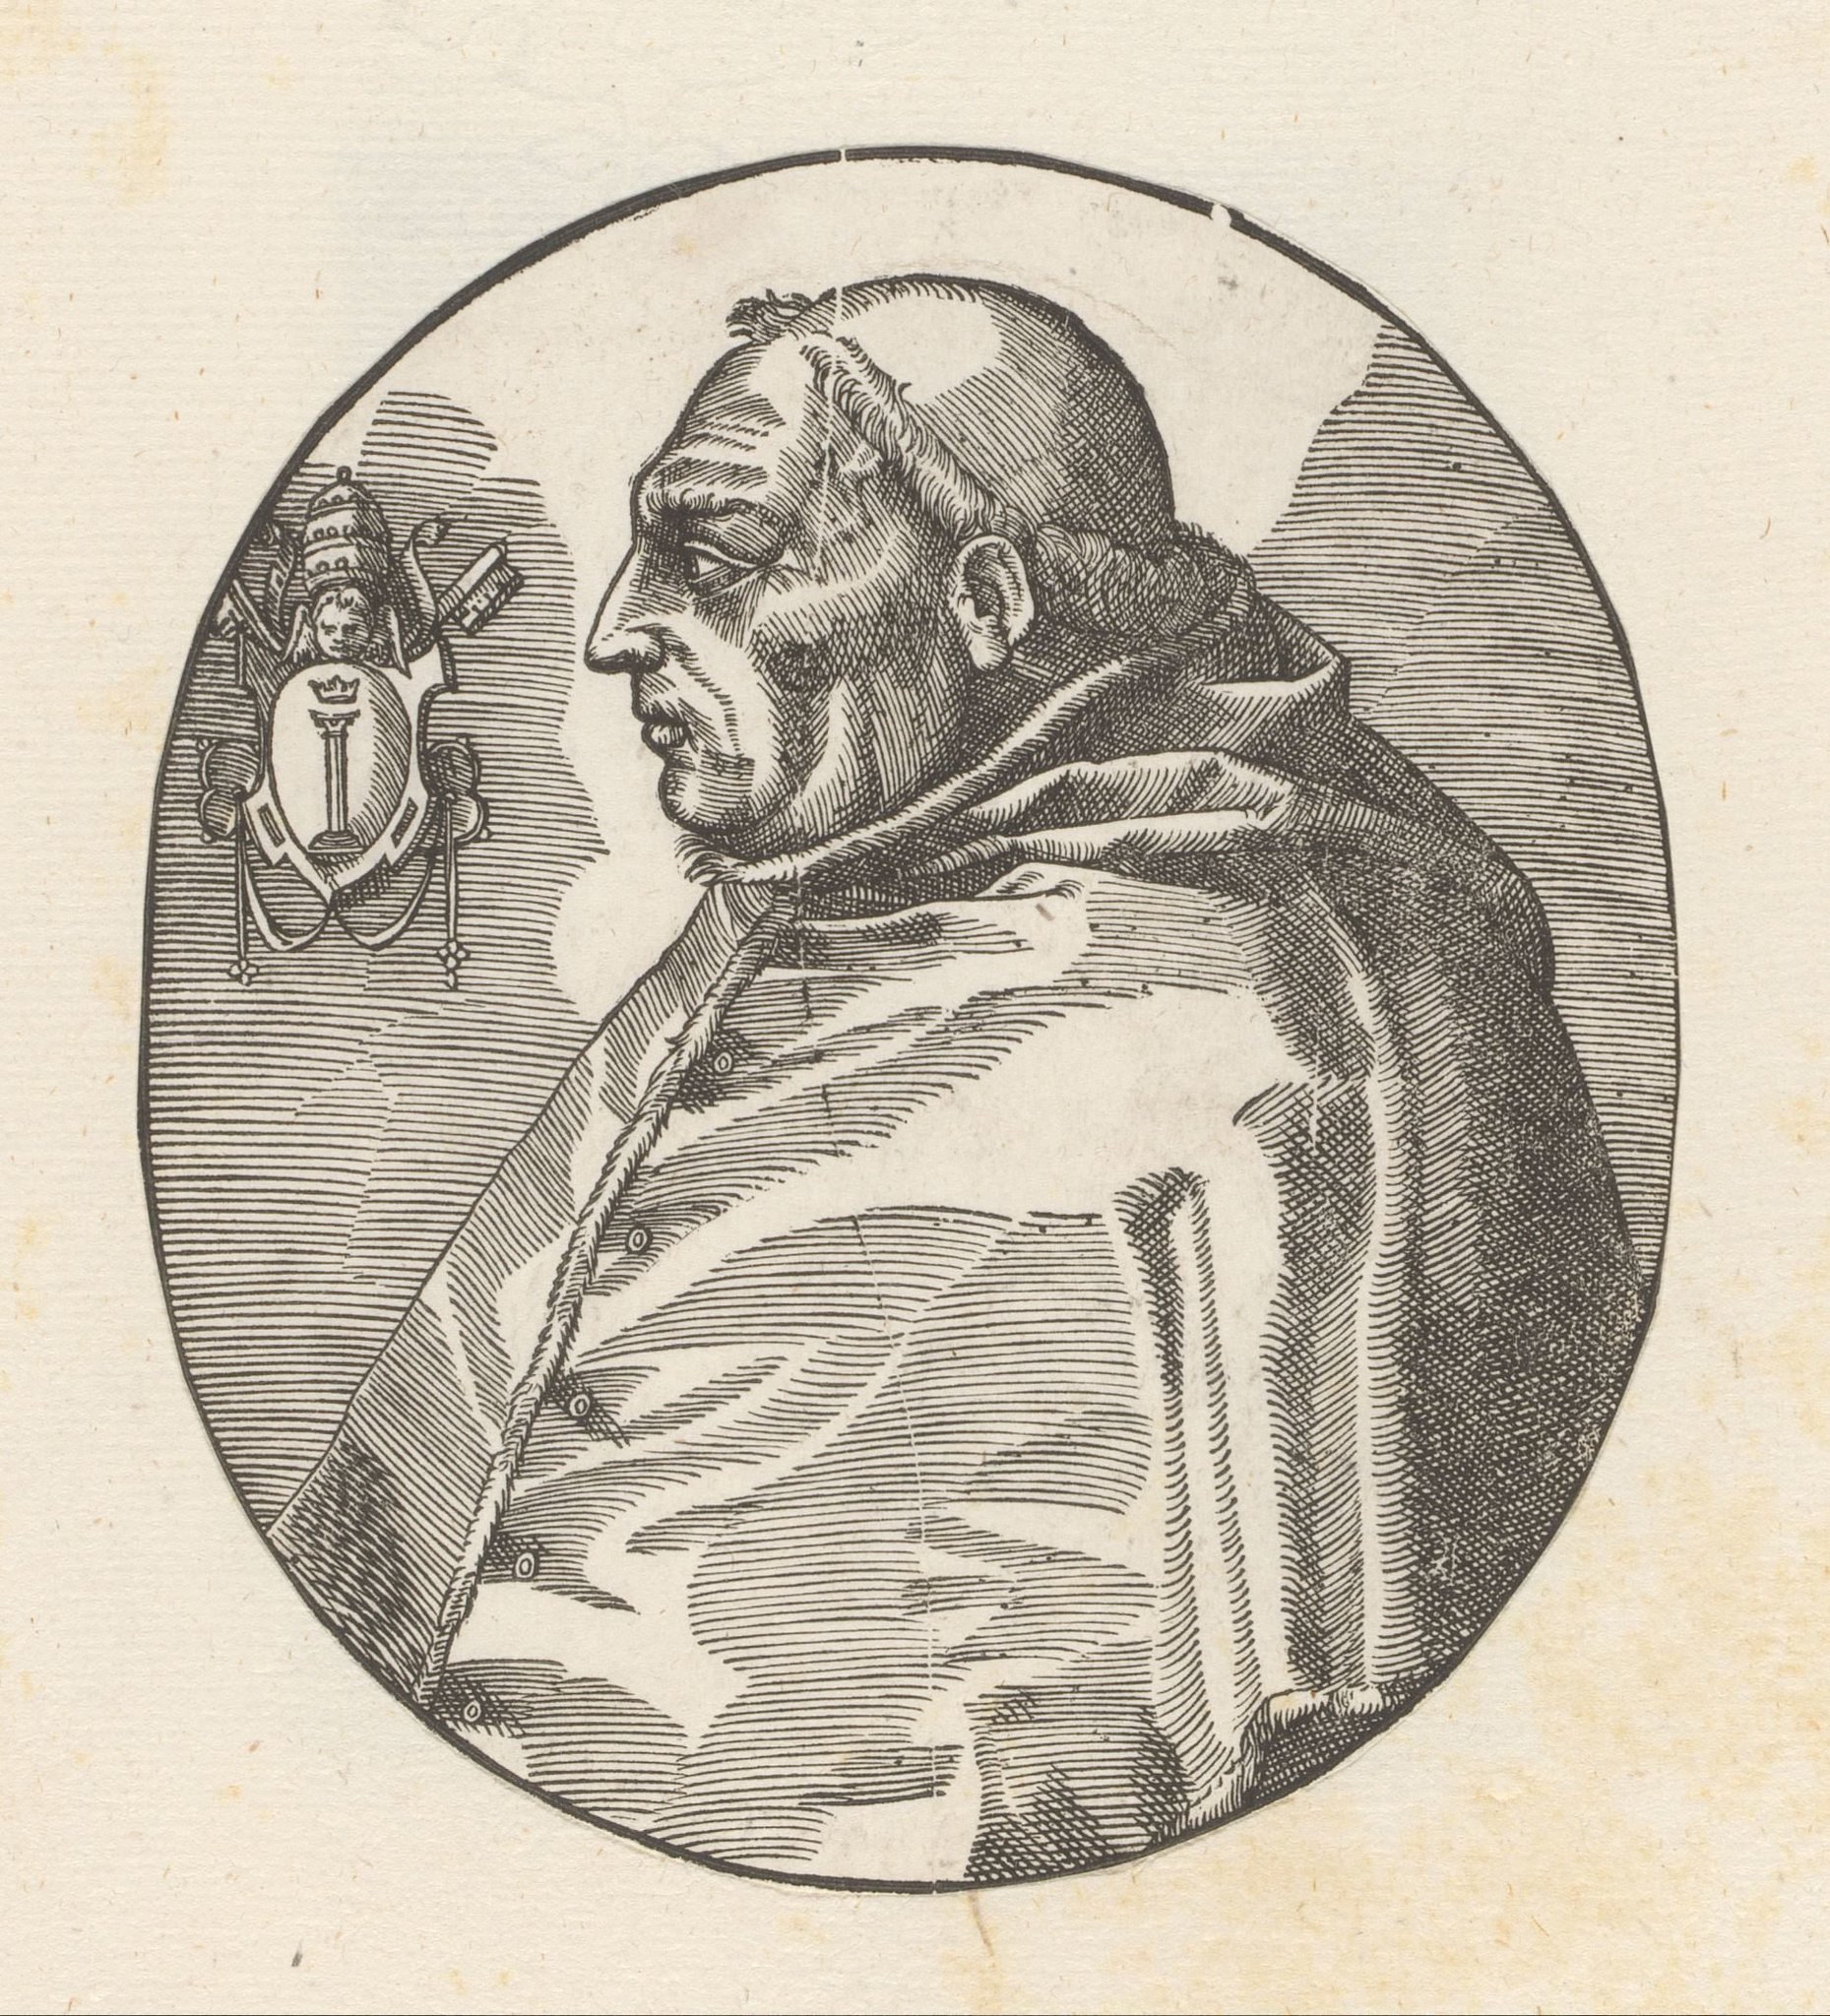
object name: book illustration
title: Portret van paus Martin V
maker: Anonymous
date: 1549-1573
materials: paper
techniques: woodcut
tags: rome, historical persons, pope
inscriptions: collector's mark: Lugt 240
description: Prent gebruikt in: Panvinio, Onofrio. Accuratae Effigies Pontificum (...). Straatsburg: Bernhard Jobin, 1573.